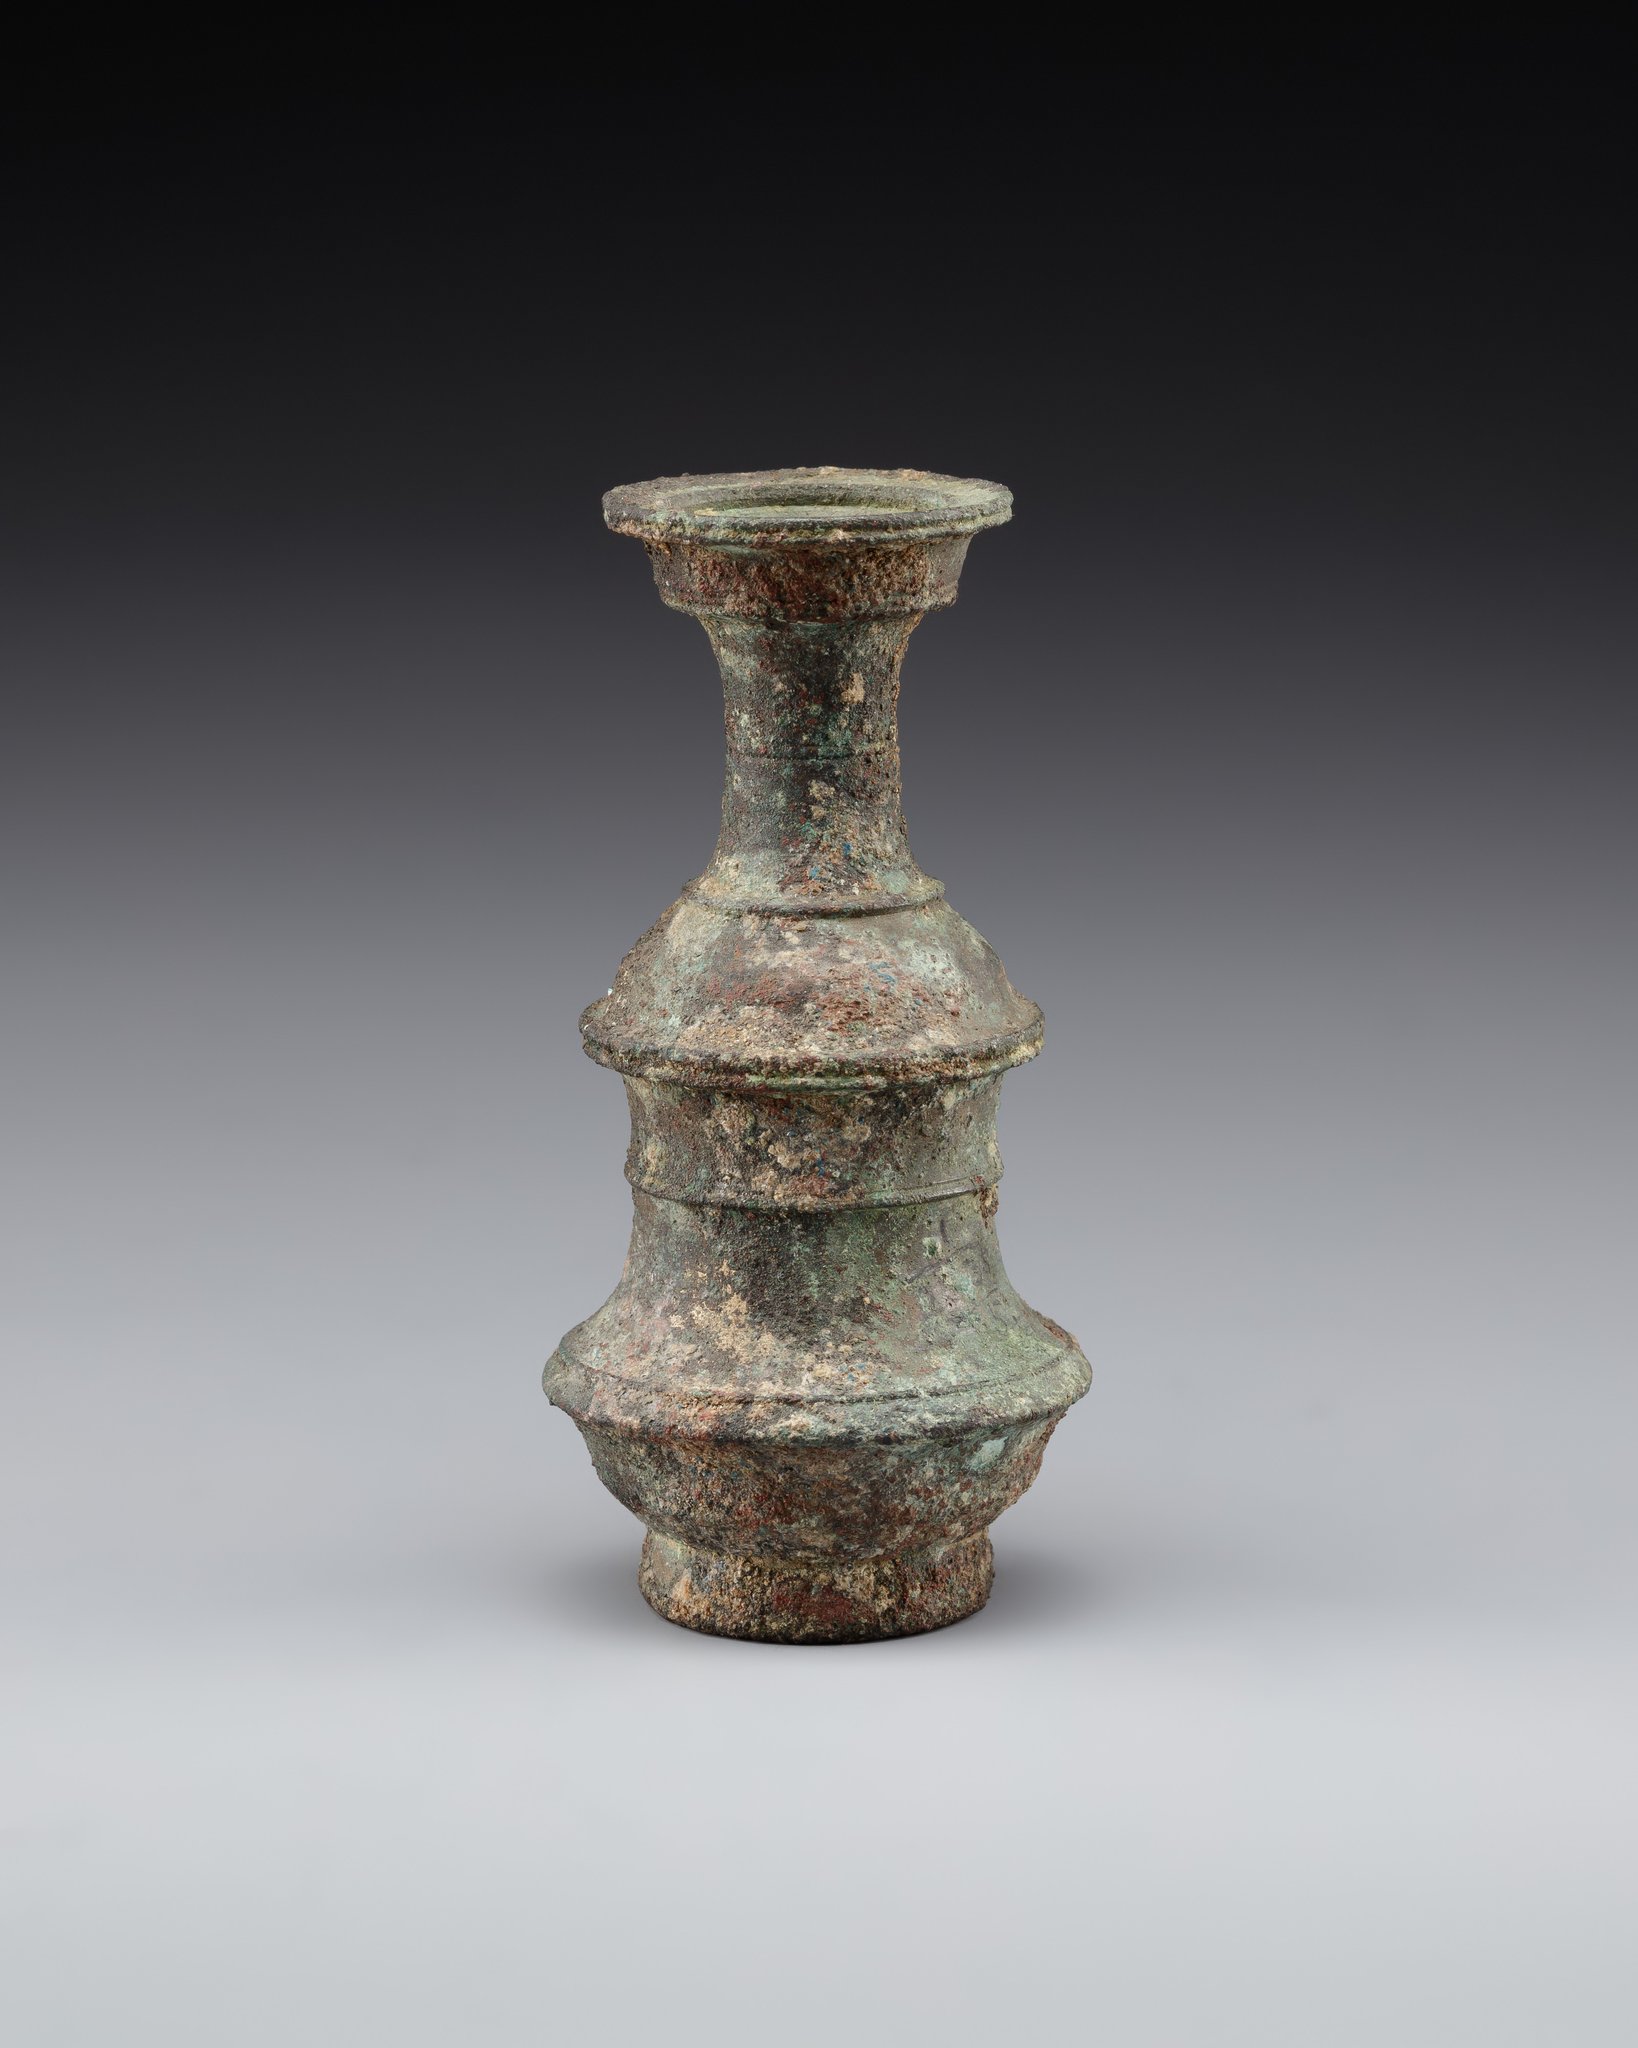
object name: pot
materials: bronze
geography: nubia